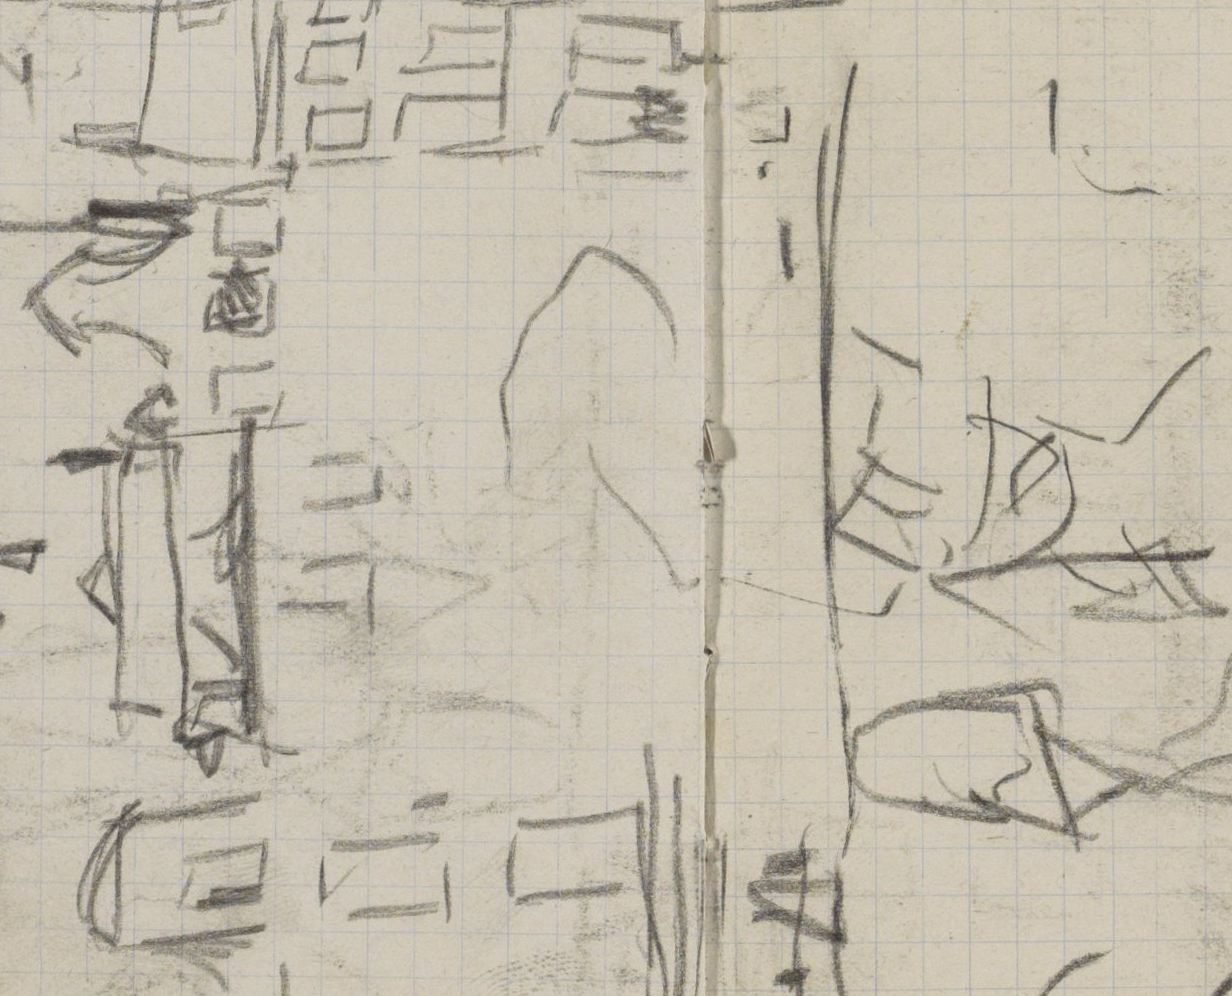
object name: sketchbook leaf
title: Gezicht op de Torensluis te Amsterdam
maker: george hendrik breitner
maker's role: draughtsman, painter, print maker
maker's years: 1857-1923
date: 1893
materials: chalk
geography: amsterdam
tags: sluice, weir, urban housing, bridge in city across river, canal, etc. (+ city(-scape) with figures, staffage)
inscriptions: annotation: ‘Torensluis/ avond geele/ lucht’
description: Pagina 43 en pagina 44 uit een schetsboek met 30 bladen vervaardigd in Amsterdam.